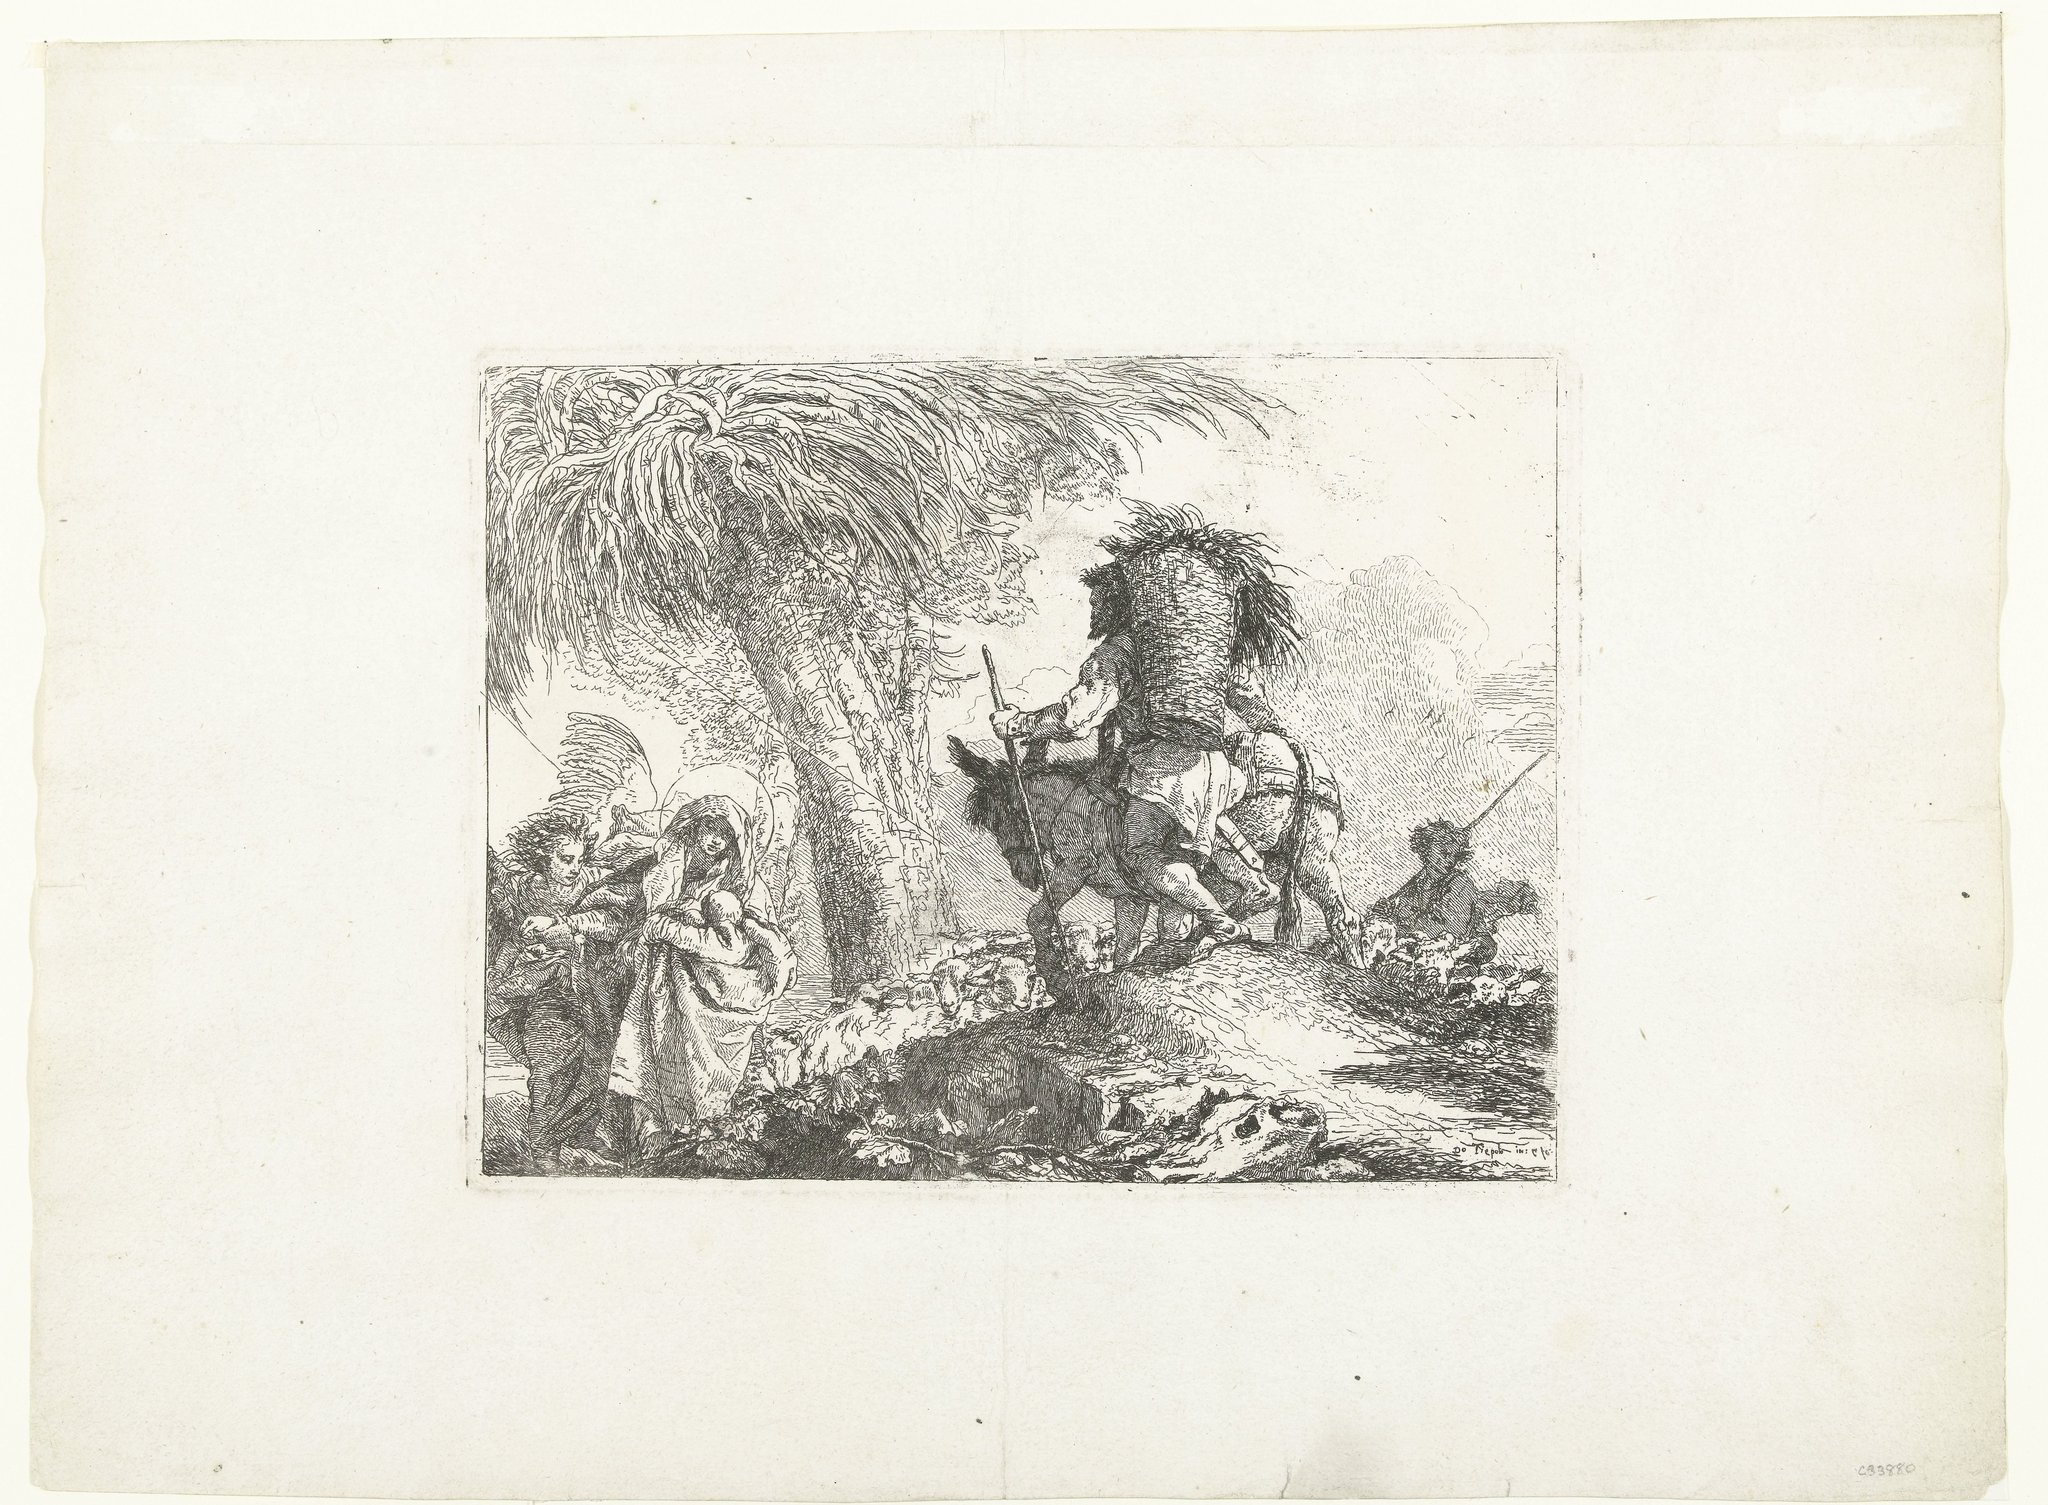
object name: print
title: Maria met Kind ondersteund door engel en Jozef leidt ezel langs herder met schapen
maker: giovanni domenico tiepolo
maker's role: draughtsman, print maker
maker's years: 1727-1804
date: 1750-1753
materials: paper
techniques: etching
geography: venice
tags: flight into egypt and miracles during the journey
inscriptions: collector's mark: Lugt 2228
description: Prent uit serie van zevenentwintig prenten met de Vlucht naar Egypte. Druk voor beschreven staat bij Rizzi 1971 waarop het nummer 24 ontbreekt.